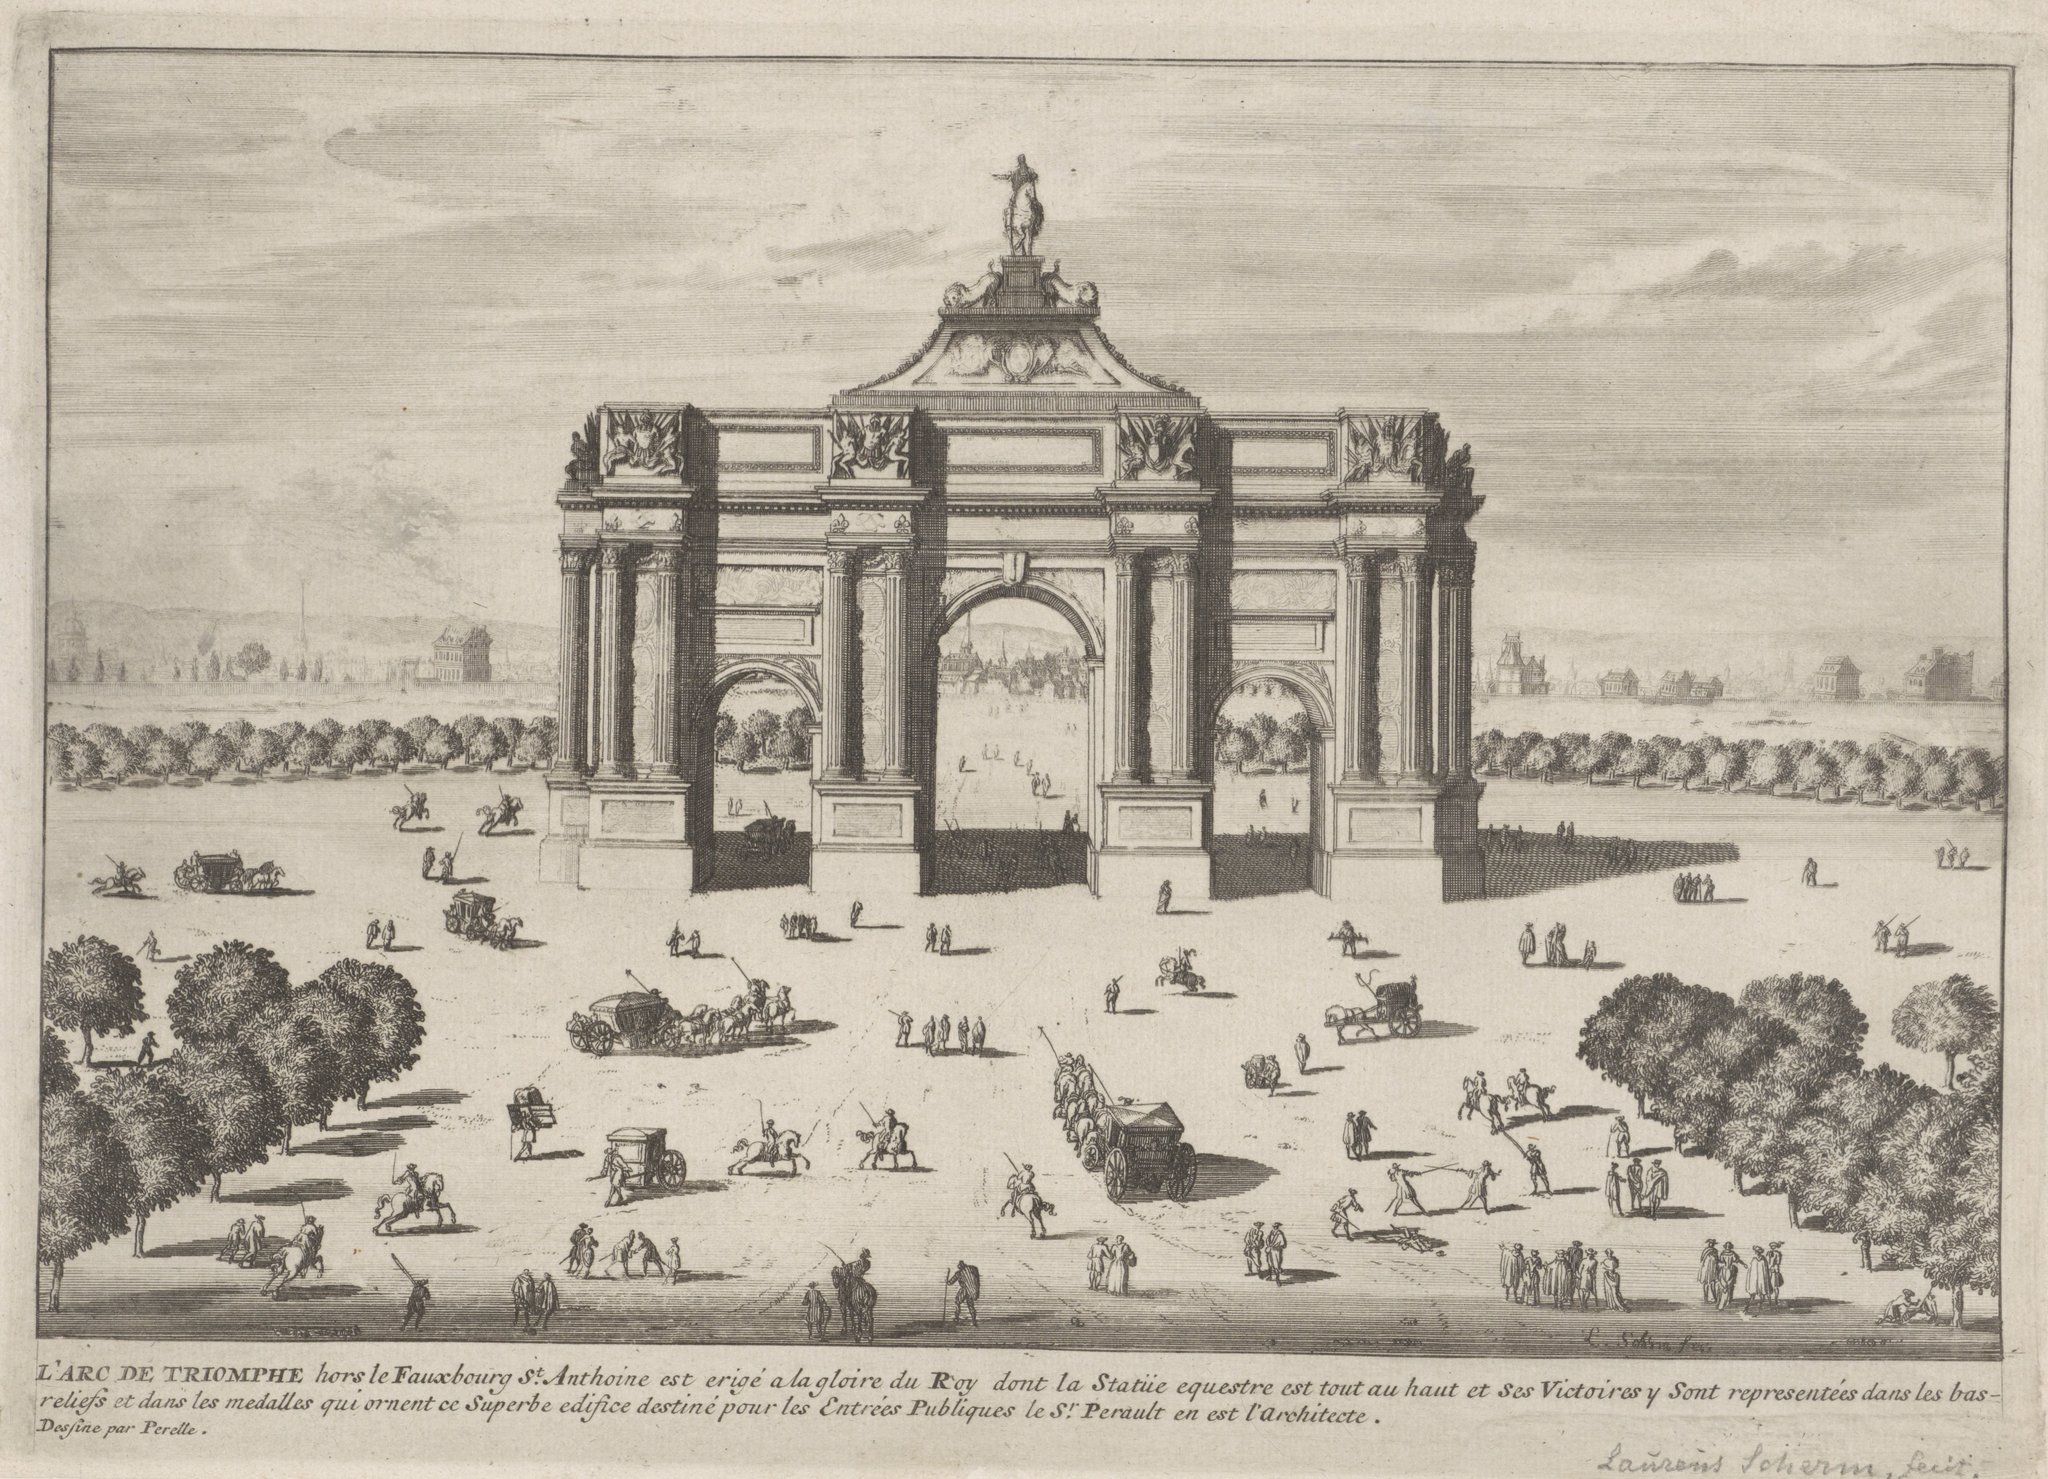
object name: print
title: l'Arc de Triomph (...)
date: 1689-1701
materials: paper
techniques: etching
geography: amsterdam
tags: triumphal arch, city-view, and landscape with man-made constructions (+ city(-scape) with figures, staffage)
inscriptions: collector's mark: Lugt 2228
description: Gezicht op de triomfboog en enkele boompartijen bij Fauxbourg Saint-Antoine, een voormalige voorstad van Parijs. Rond de triomfboog koetsen en wandelaars. In de verte staan nog enkele gebouwen.